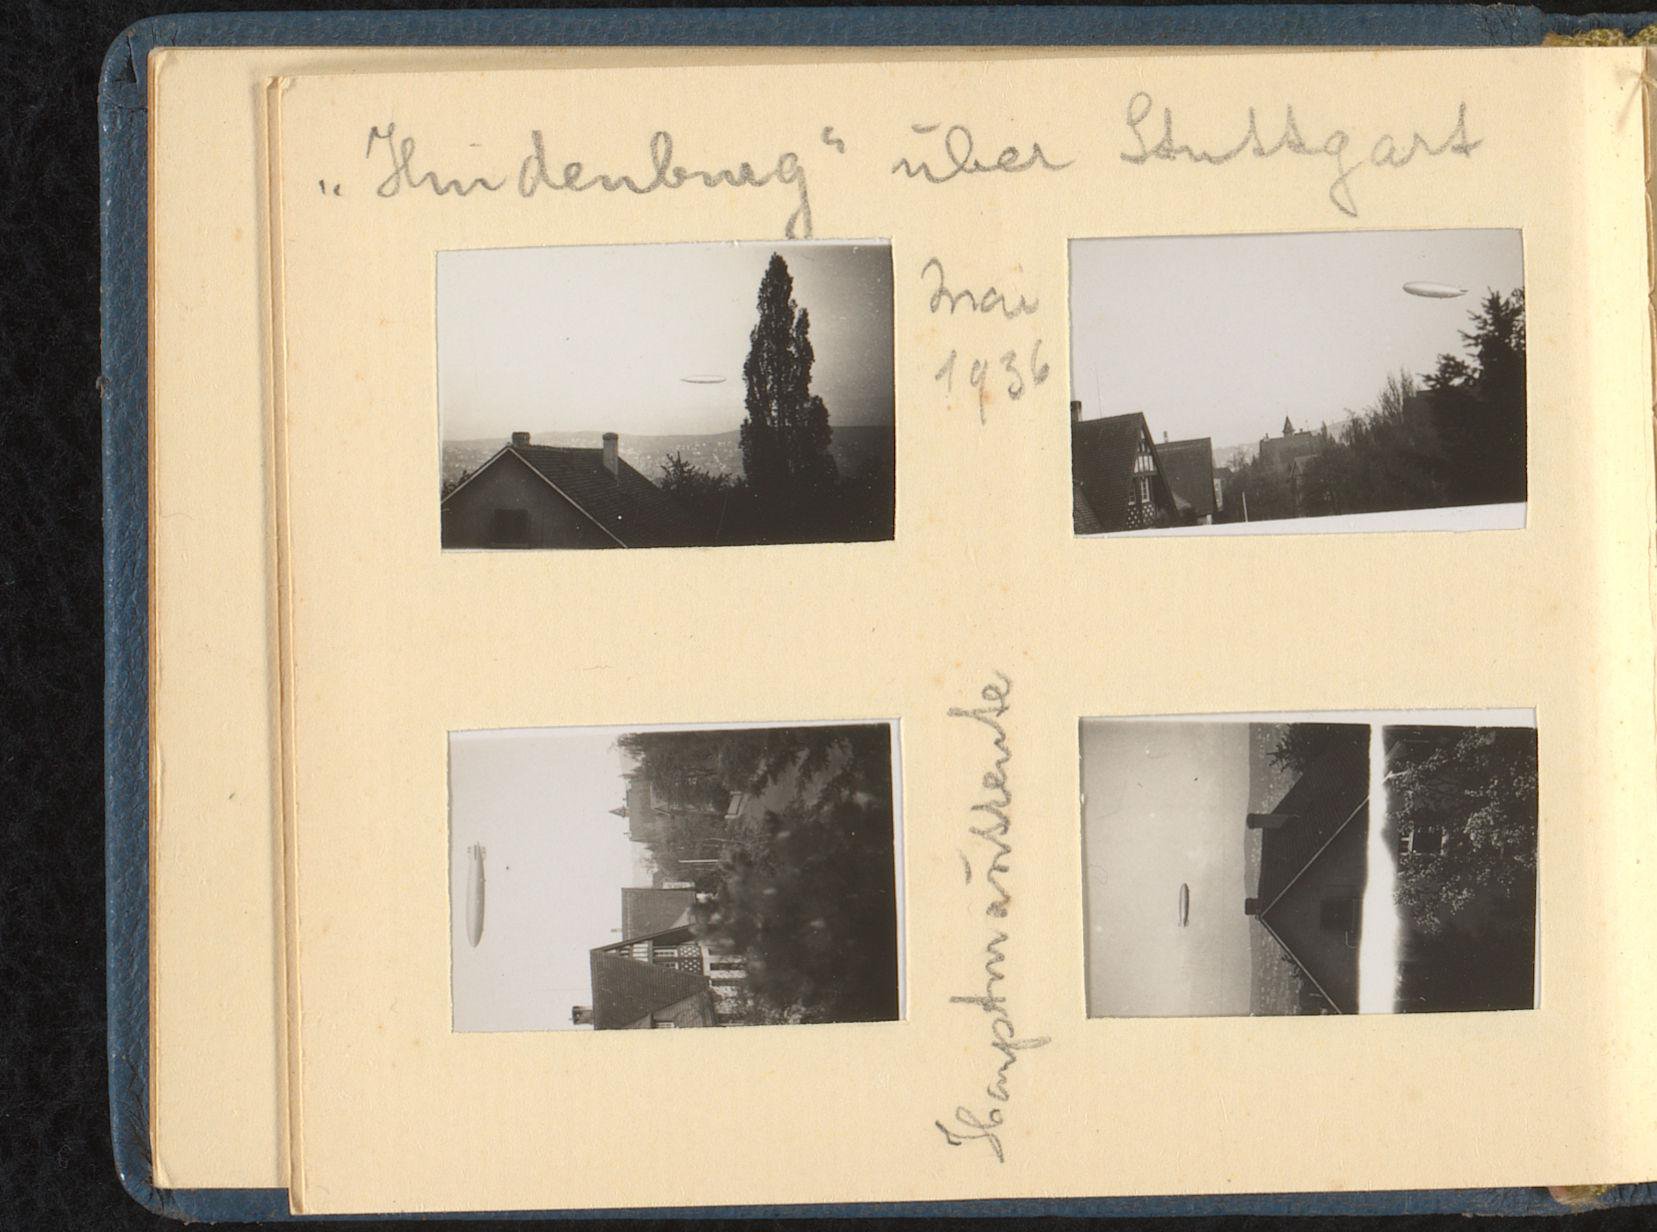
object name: album leaf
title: Zeppelin de Hindenburg vliegt over Stuttgart, genomen vanuit der woning van de familie Wachenheimer aan de Hauptmannsreute, mei 1936, Stuttgart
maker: else wachenheimer-moos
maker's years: 1895-1944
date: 1905-1936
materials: paper, photographic support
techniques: gelatin silver print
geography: stuttgart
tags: 46c35 airship, zeppelin, public road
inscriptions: inscription: ‘,,Hindenburg" über Stuttgart mai 1936 Hauptmannsreute’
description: Albumblad bevat vier foto's. Zonder personen gerelateerd aan de familie Wachenheimer. Uit klein formaat fotoalbum, blauw lederen omslag met drukknopsluiting. Met foto's in klein formaat.